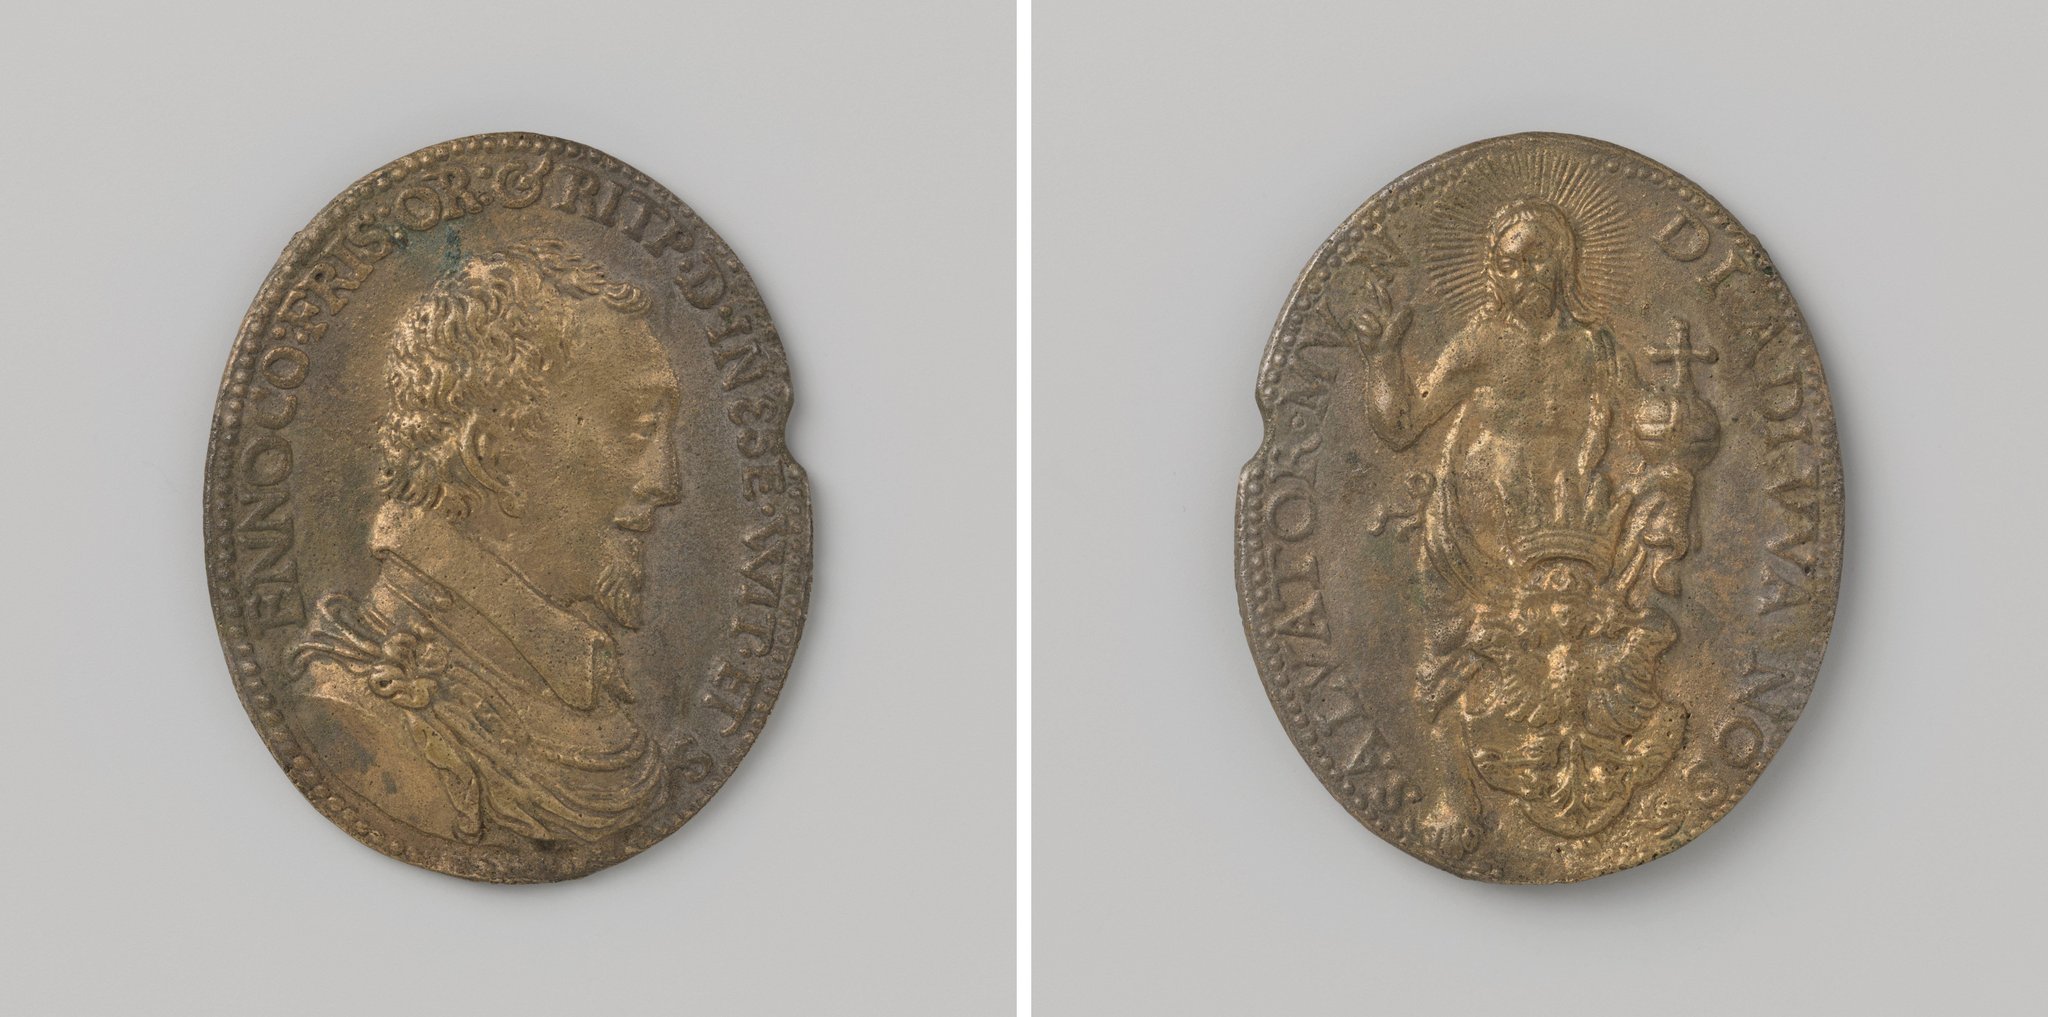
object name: copy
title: Enno III, graaf van Oost-Friesland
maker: Anonymous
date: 1603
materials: metal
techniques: casting, gilding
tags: enno iii (graaf van oost-friesland)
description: ovale penning. Voorzijde: borststuk man binnen omschrift. Keerzijde: Christus met aureool houdt rijksappel in linkerhand en steekt twee vingers van rechterhand omhoog; voor hem gekroond wapenschild binnen omschrift